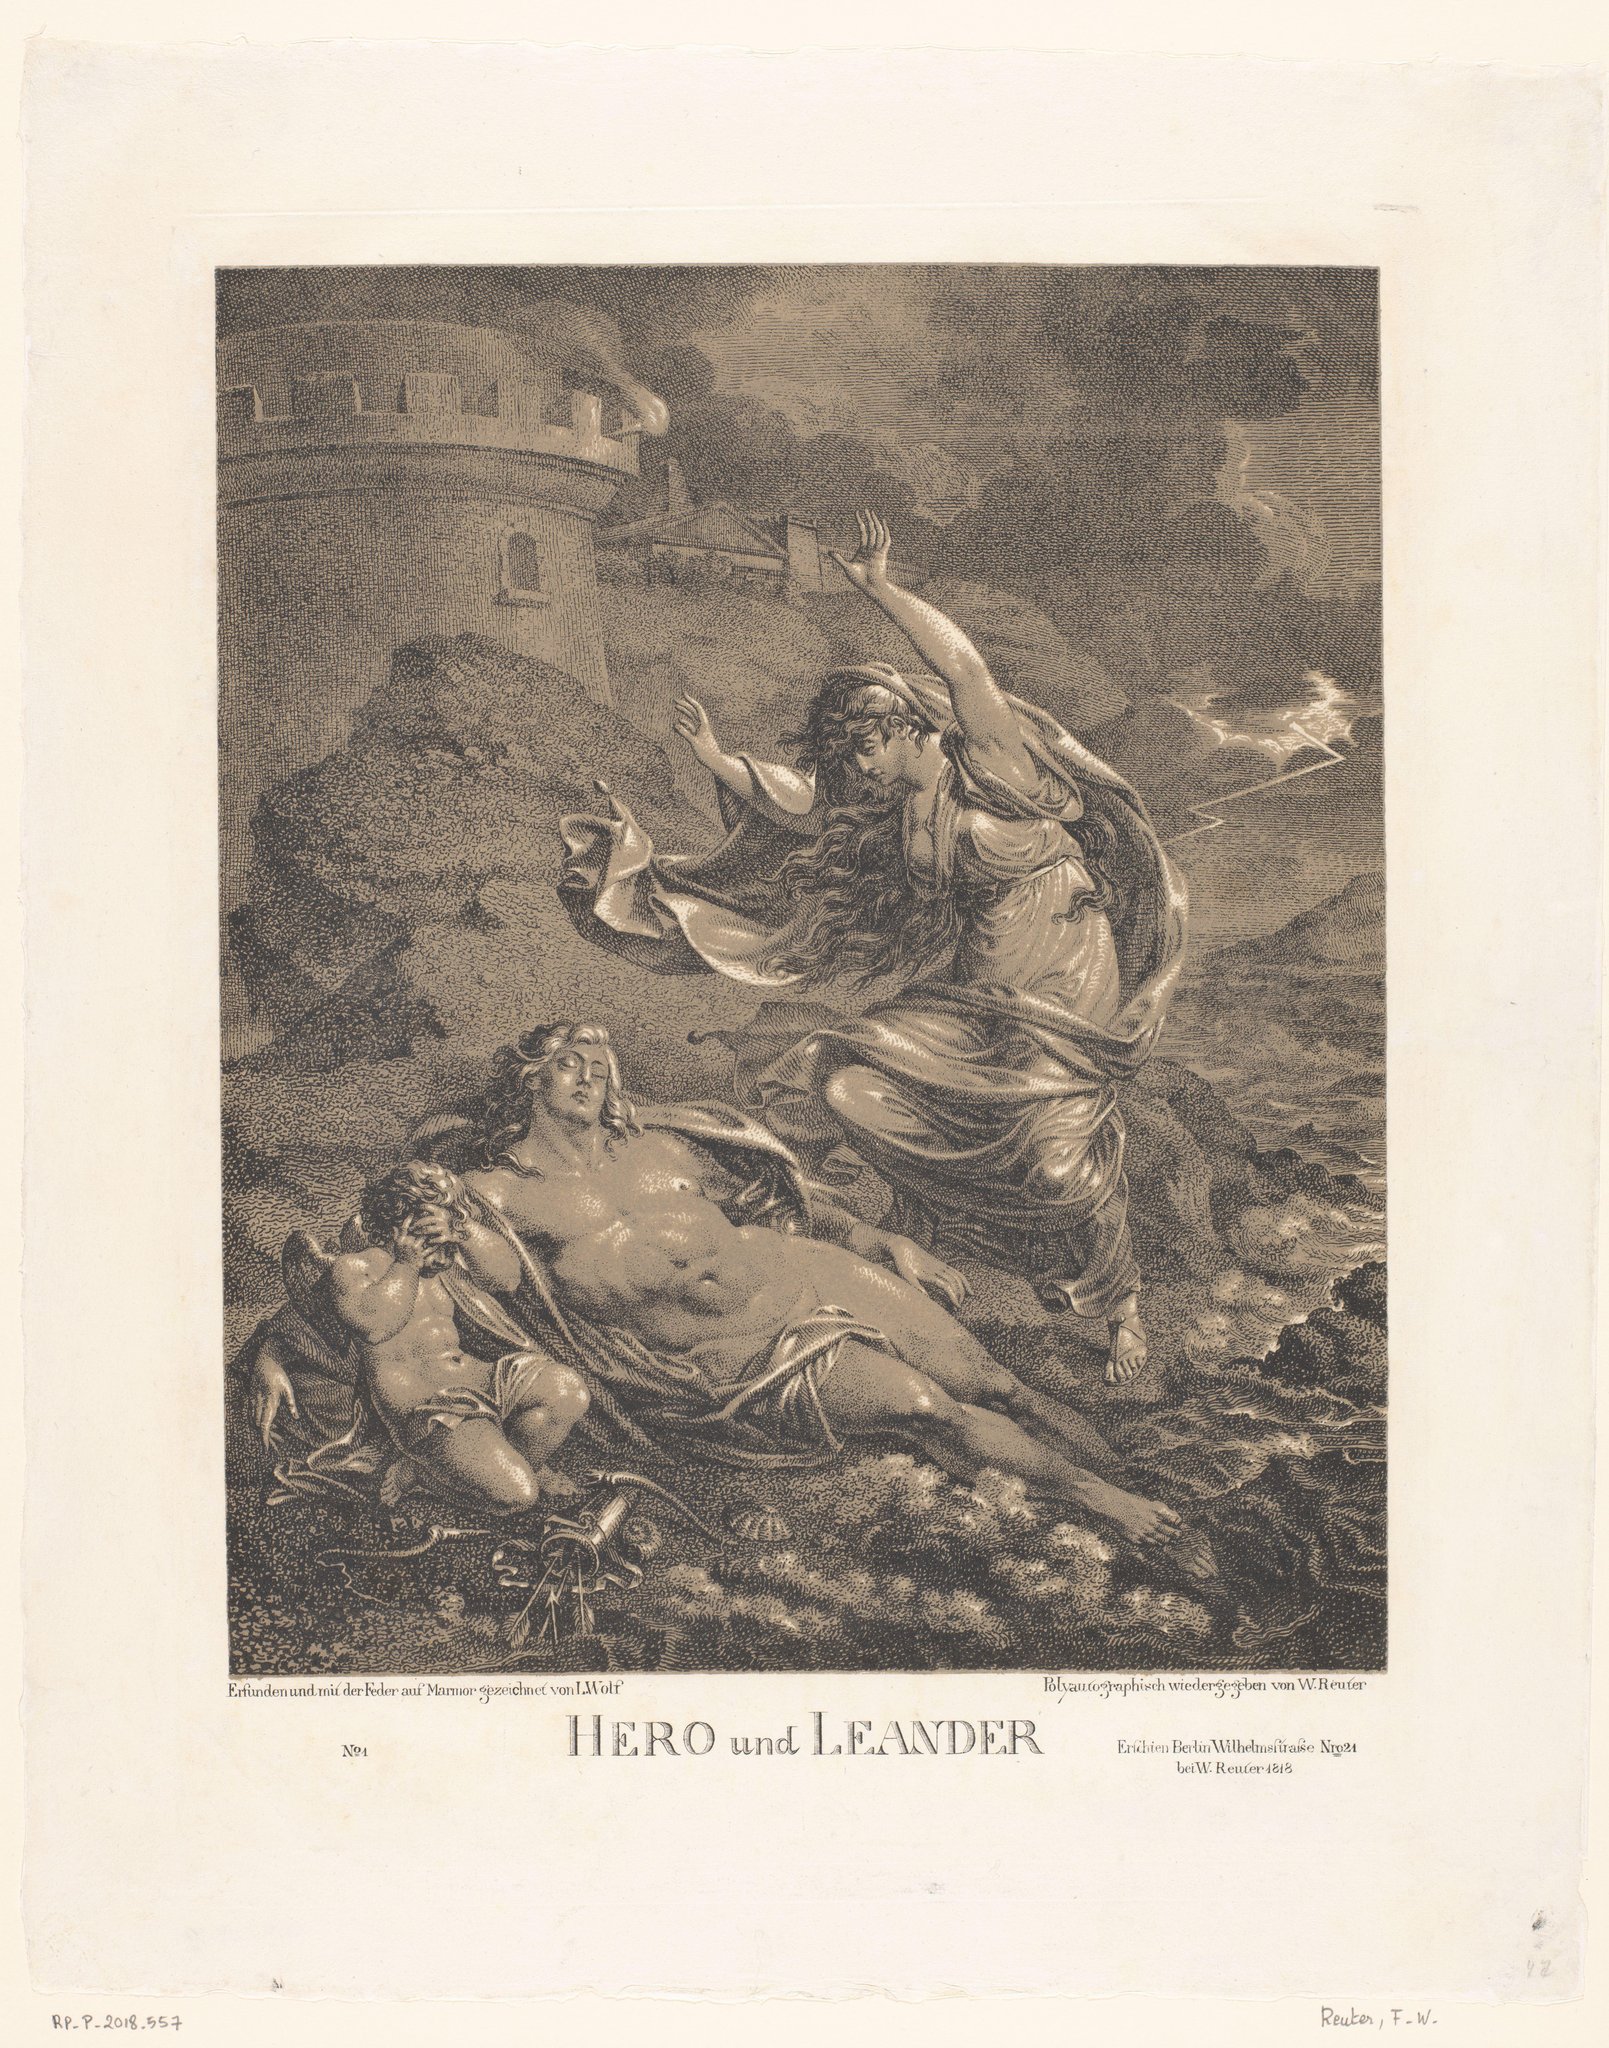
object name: print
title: Hero en Leander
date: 1818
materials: paper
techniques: lithograph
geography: berlin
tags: hero mourning the dead leander on the sea-shore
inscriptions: collector's mark: Lugt 2760, collector's mark: Lugt 2228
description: Hero vindt het aangespoelde lichaam van de verdronken Leander aan de kust. Links een treurende Cupido.